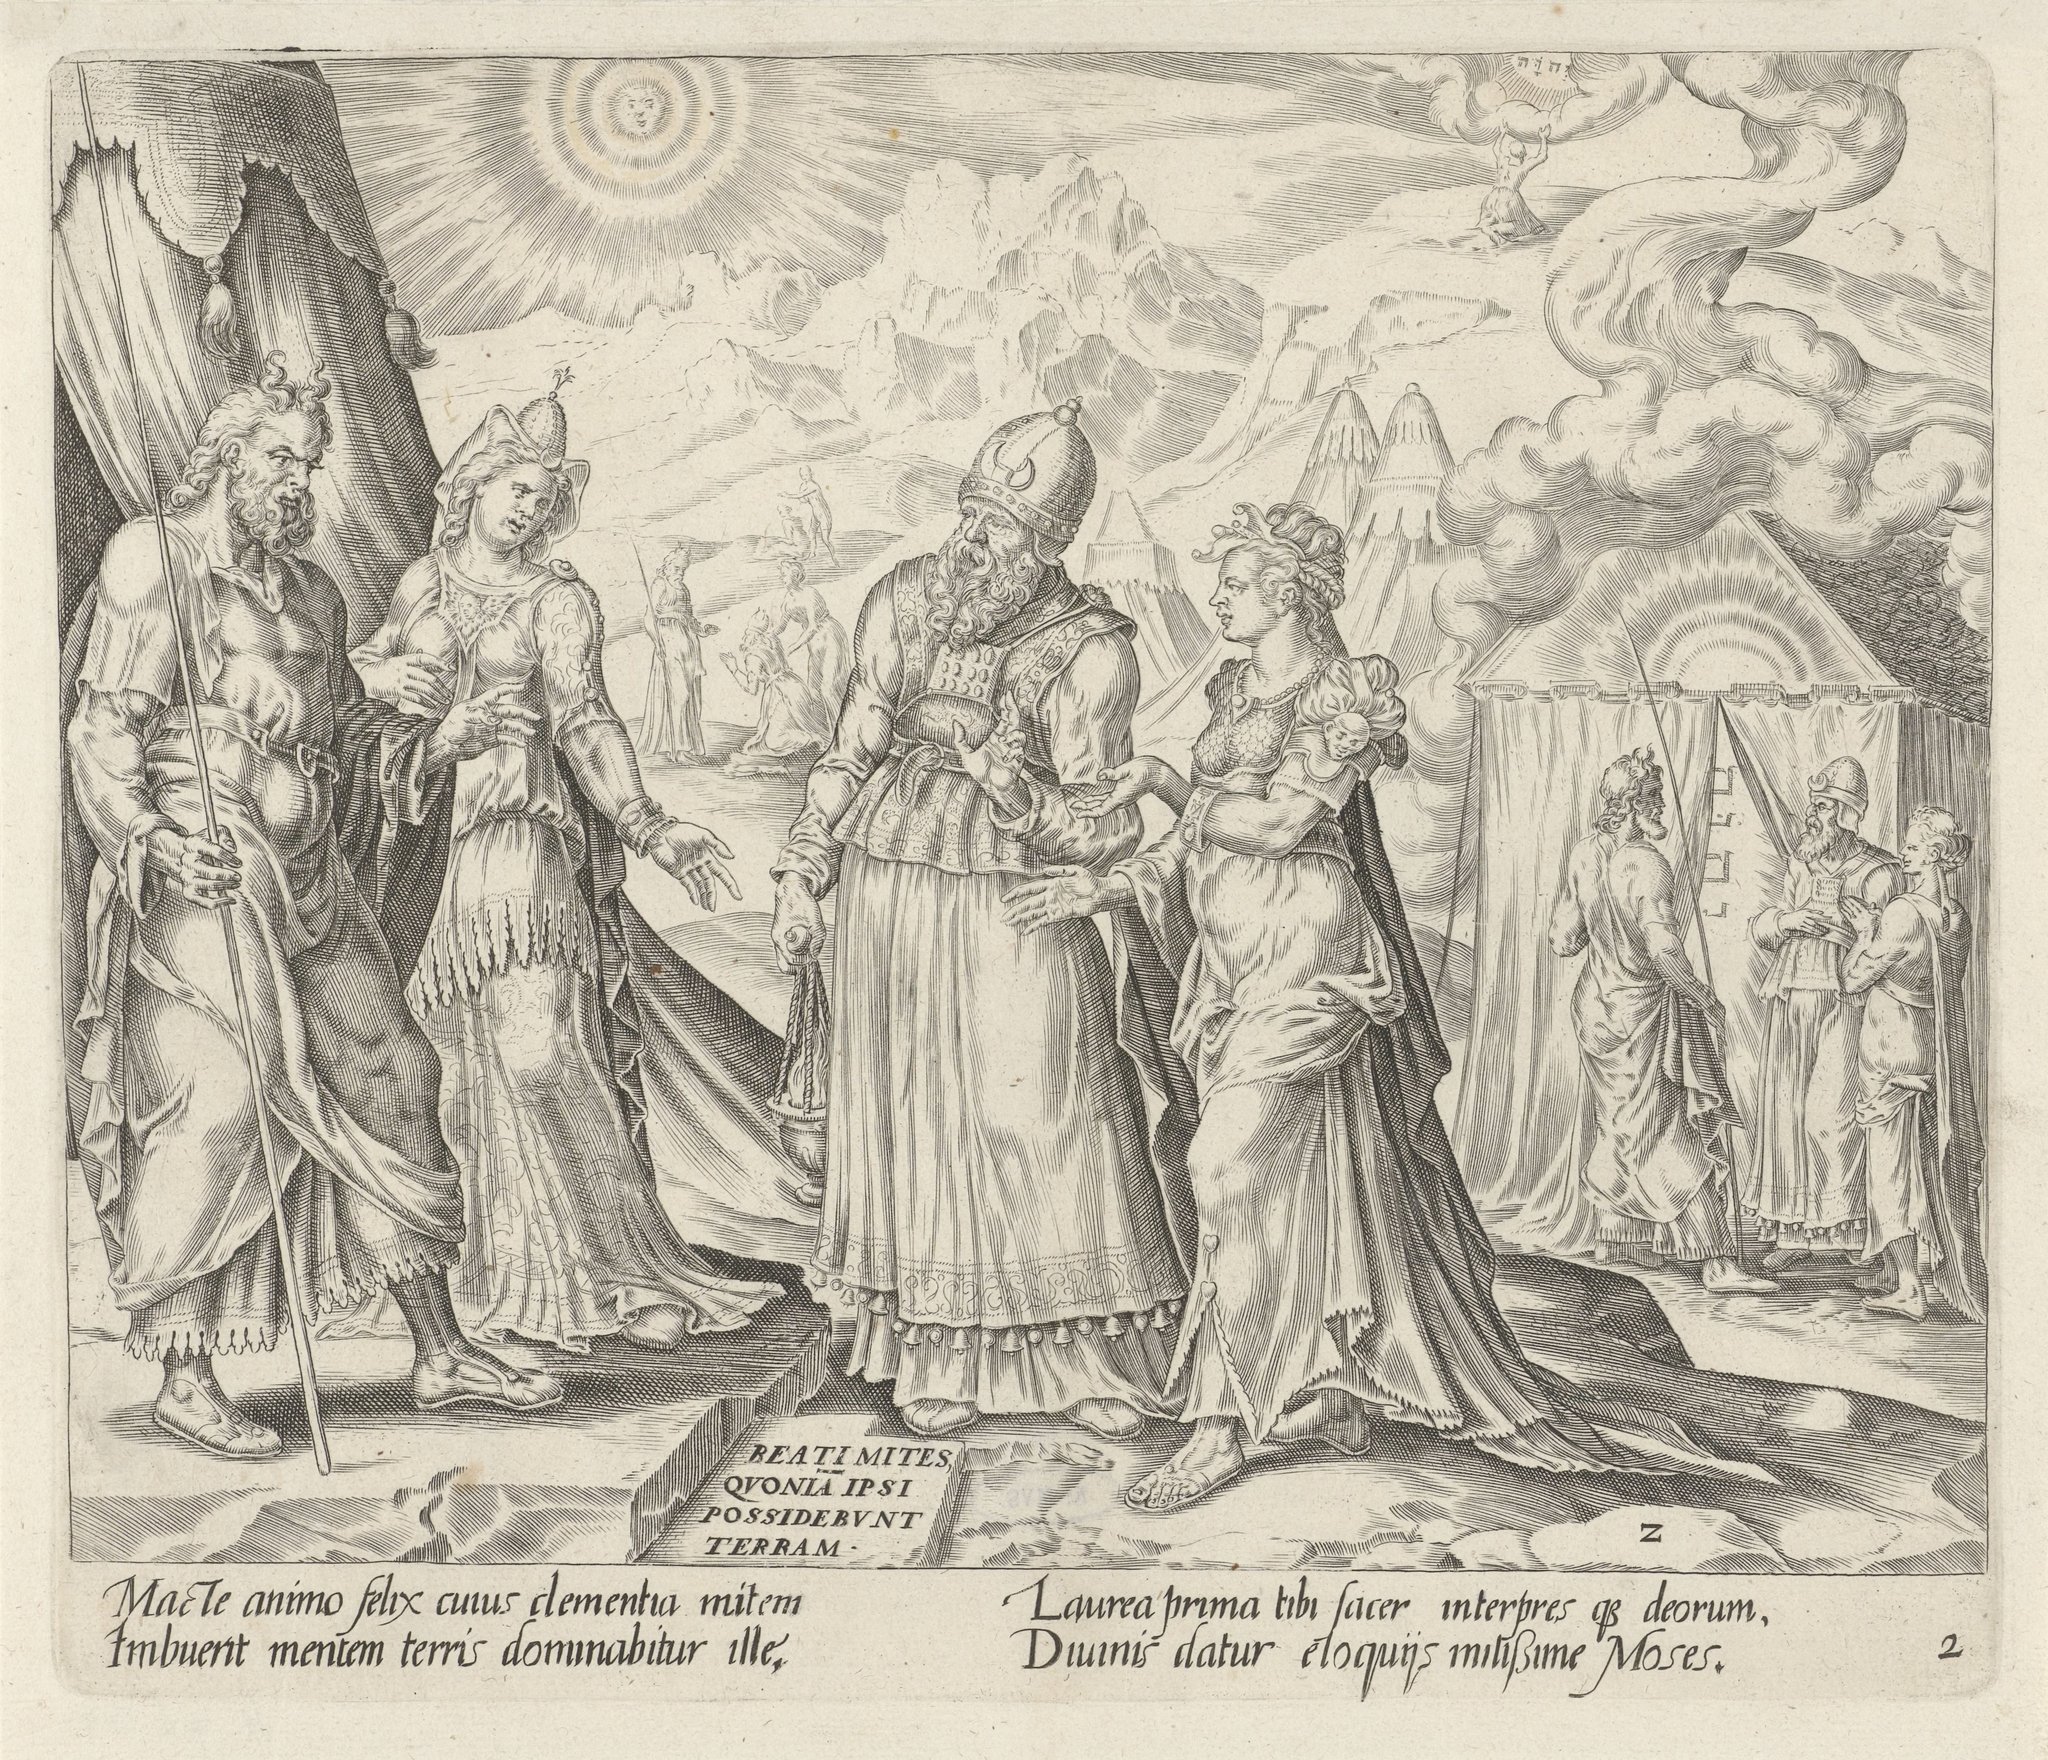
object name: print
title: Zalig zijn de zachtmoedigen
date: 1564-1568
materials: paper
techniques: engraving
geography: amsterdam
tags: blessed are the meek, sedition of miriam and aaron (numbers 12)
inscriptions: collector's mark: Lugt 2228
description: Aäron en Mirjam staan voor Mozes en zijn Nubische vrouw en betwisten zijn gezag door aanmerkingen te maken over zijn huwelijk met haar. Rechts spreken Mozes, Aäron en Mirjam met God, die in de vorm van het tetragram in de deuropening van de verbondstent verschijnt. In het landschap smeekt Aäron op zijn knieën Mozes om zijn zonde niet aan te rekenen. Mirjam zit getroffen door huidvraat in de woestijn. Op de berg bidt Mozes om genezing voor haar. Prent maakt deel uit van een serie over de acht zaligsprekingen van Christus en illustreert de zaligspreking: Zalig zijn de zachtmoedigen. Op de trap een steen met deze tekst uit Mat. 5:5 in het Latijn. Onderaan in de marge een vers in het Latijn over de zaligspreking en de voorstelling.